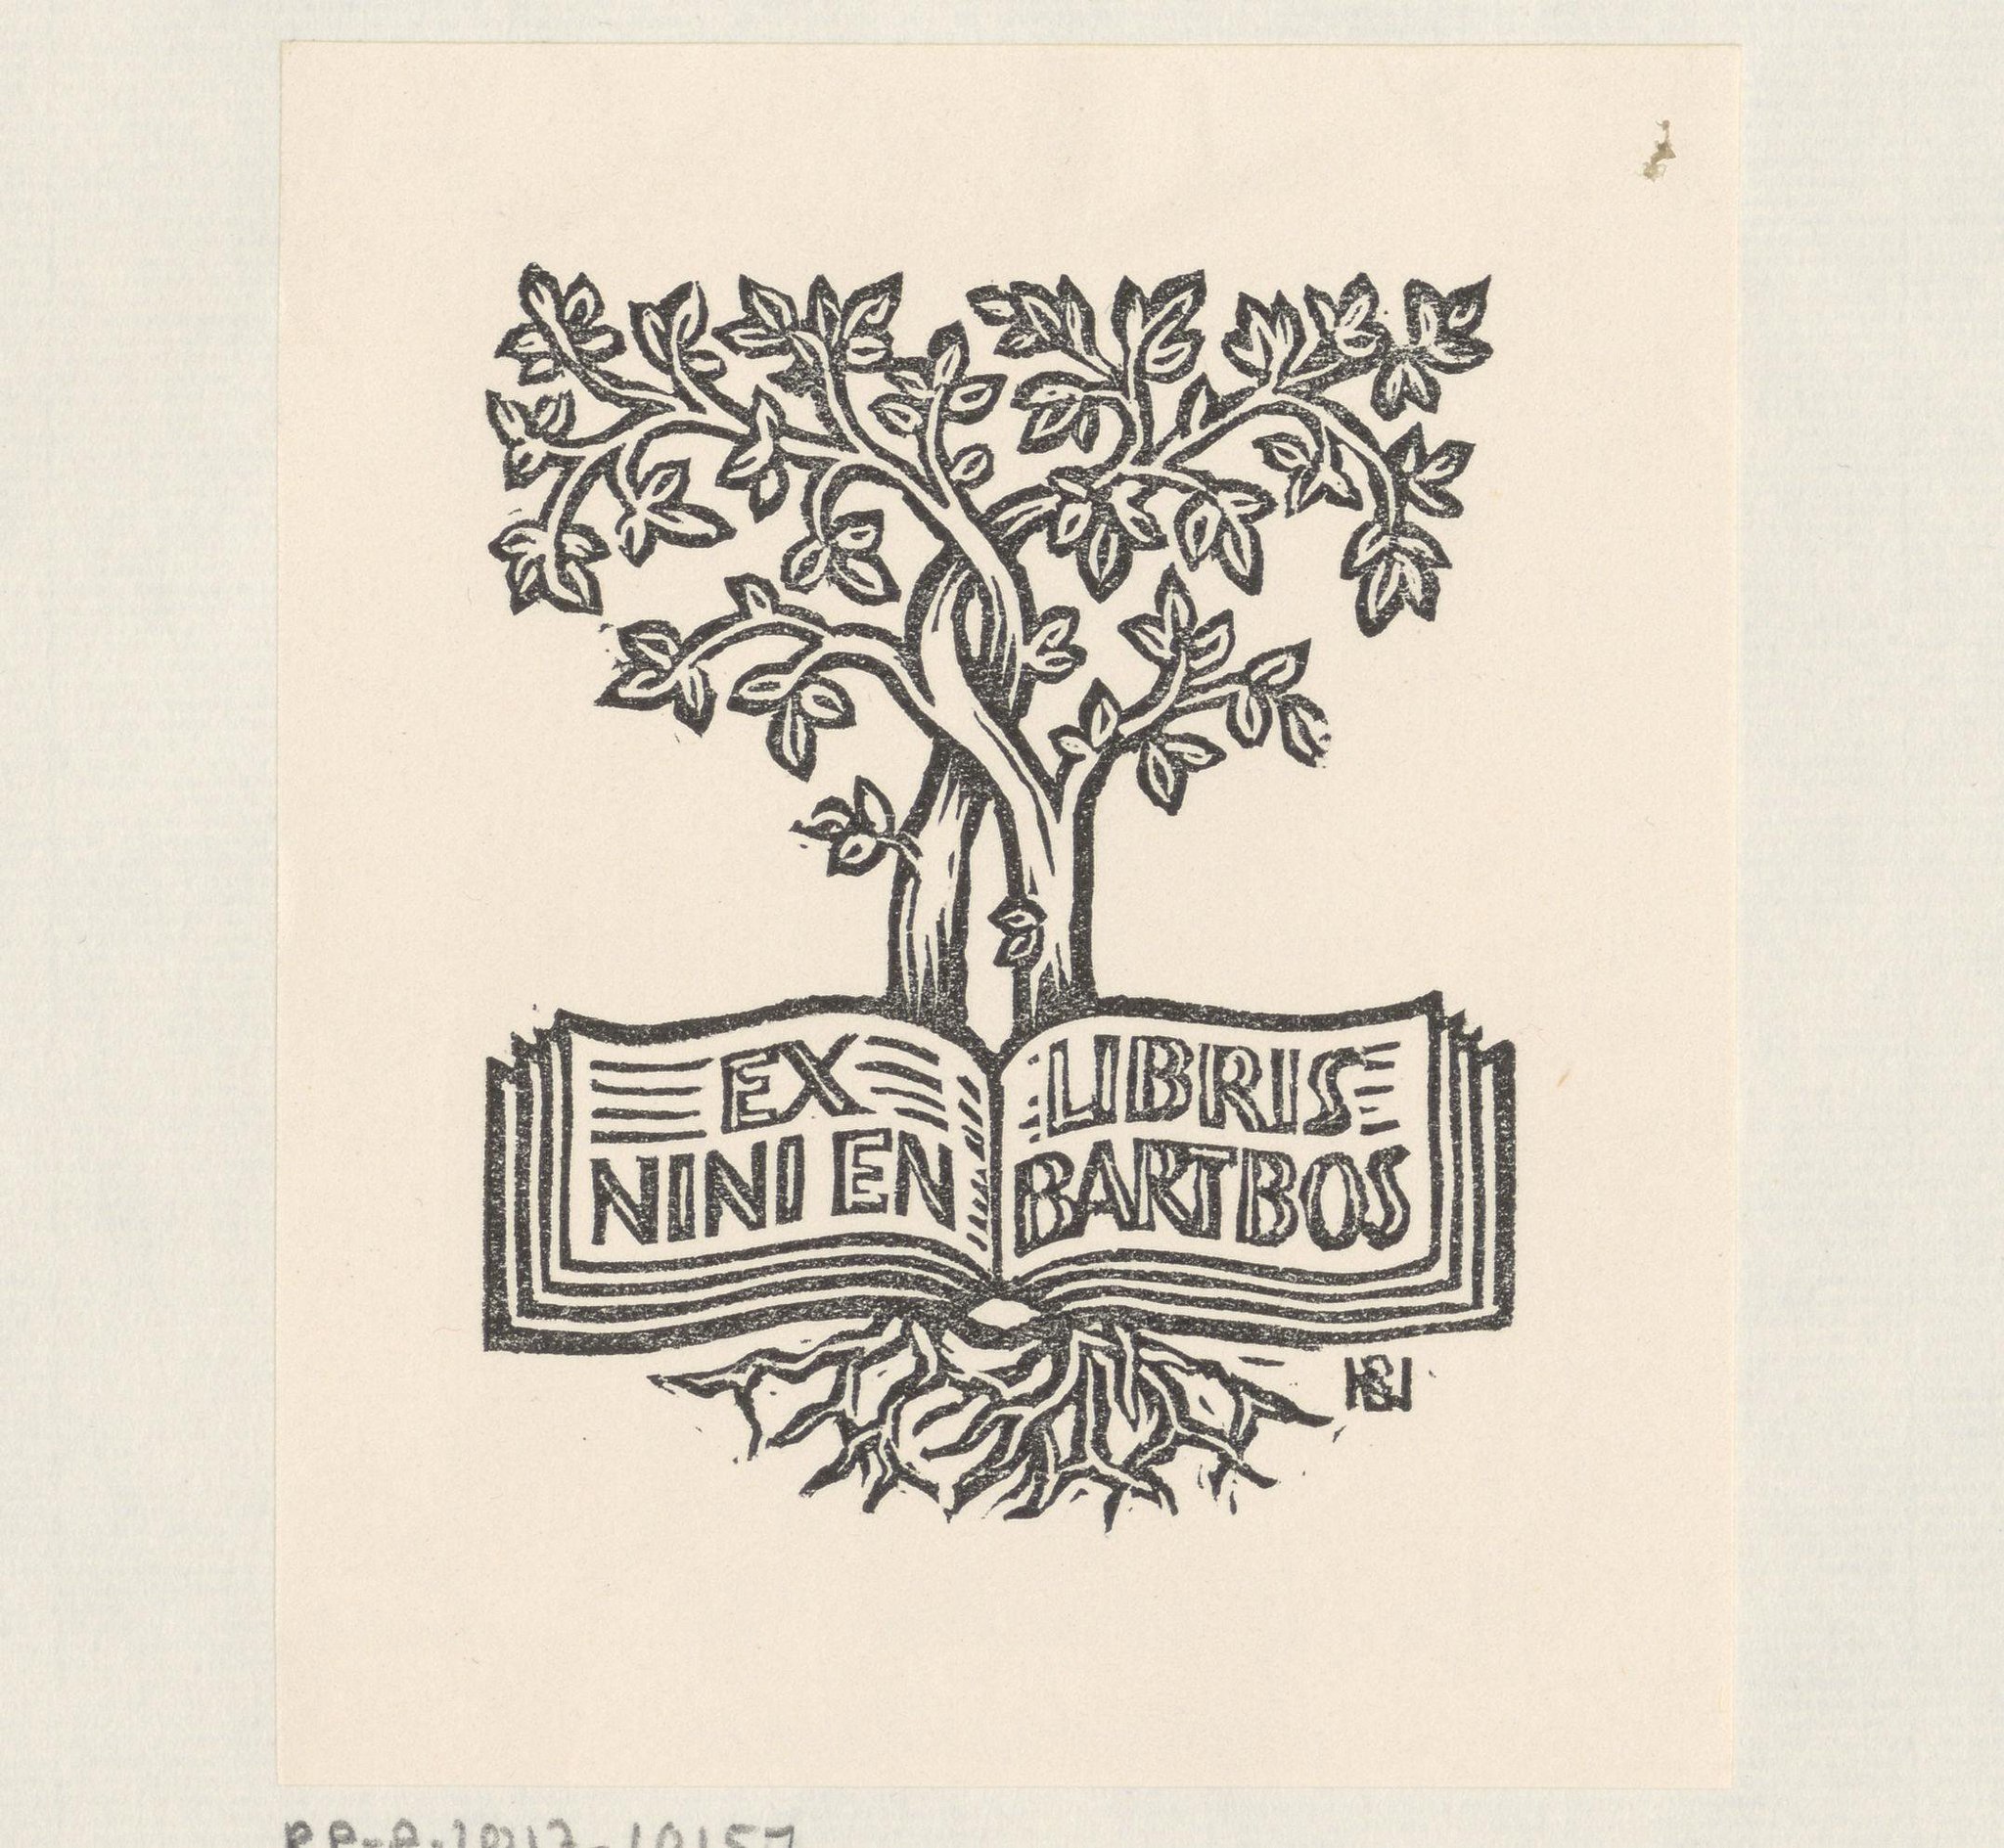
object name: bookplate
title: Ex libris van Nini en Bart Bos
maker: berthl nacken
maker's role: print maker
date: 1950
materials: paper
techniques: linocut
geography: germany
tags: bart bos, trees, book